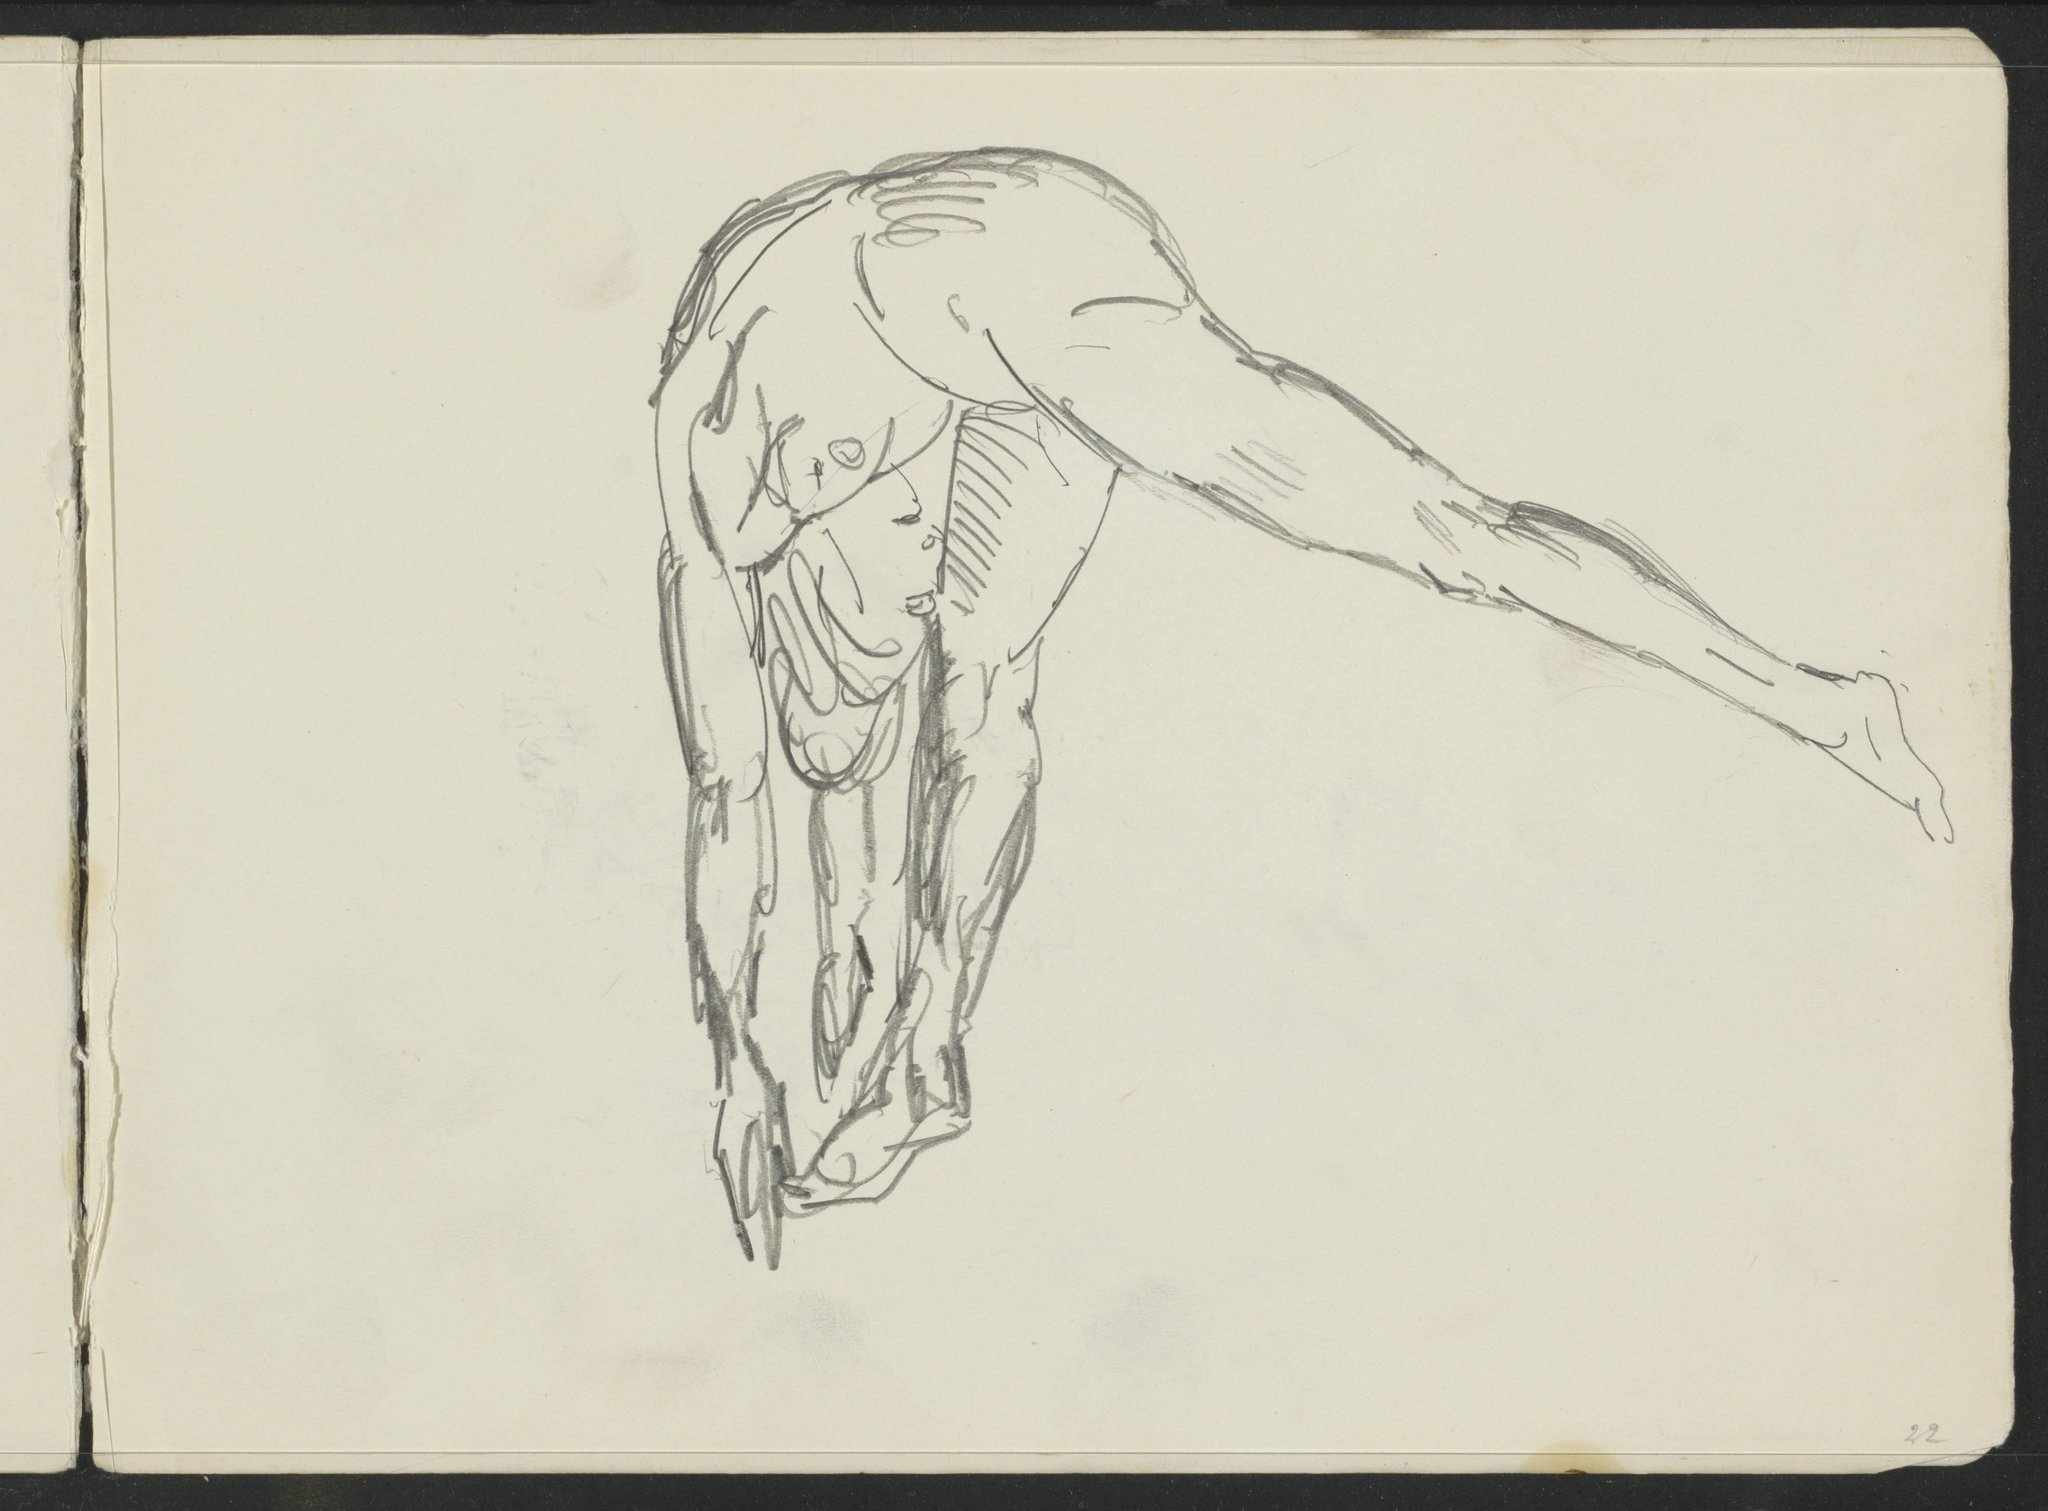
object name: sketchbook leaf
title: Gymnastiekend vrouwelijk naakt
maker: isaac israels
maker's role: draughtsman, painter, print maker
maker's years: 1865-1934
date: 1915-1934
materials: paper, pencil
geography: the hague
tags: gymnastic exercises on the ground, the (nude) human figure; 'corpo humano' (ripa) - aa - female human figure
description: Ze strekt haar armen en benen en drukt haar neus tegen haar bovenbeen. Blad 22 recto uit schetsboek XV met 22 bladen.